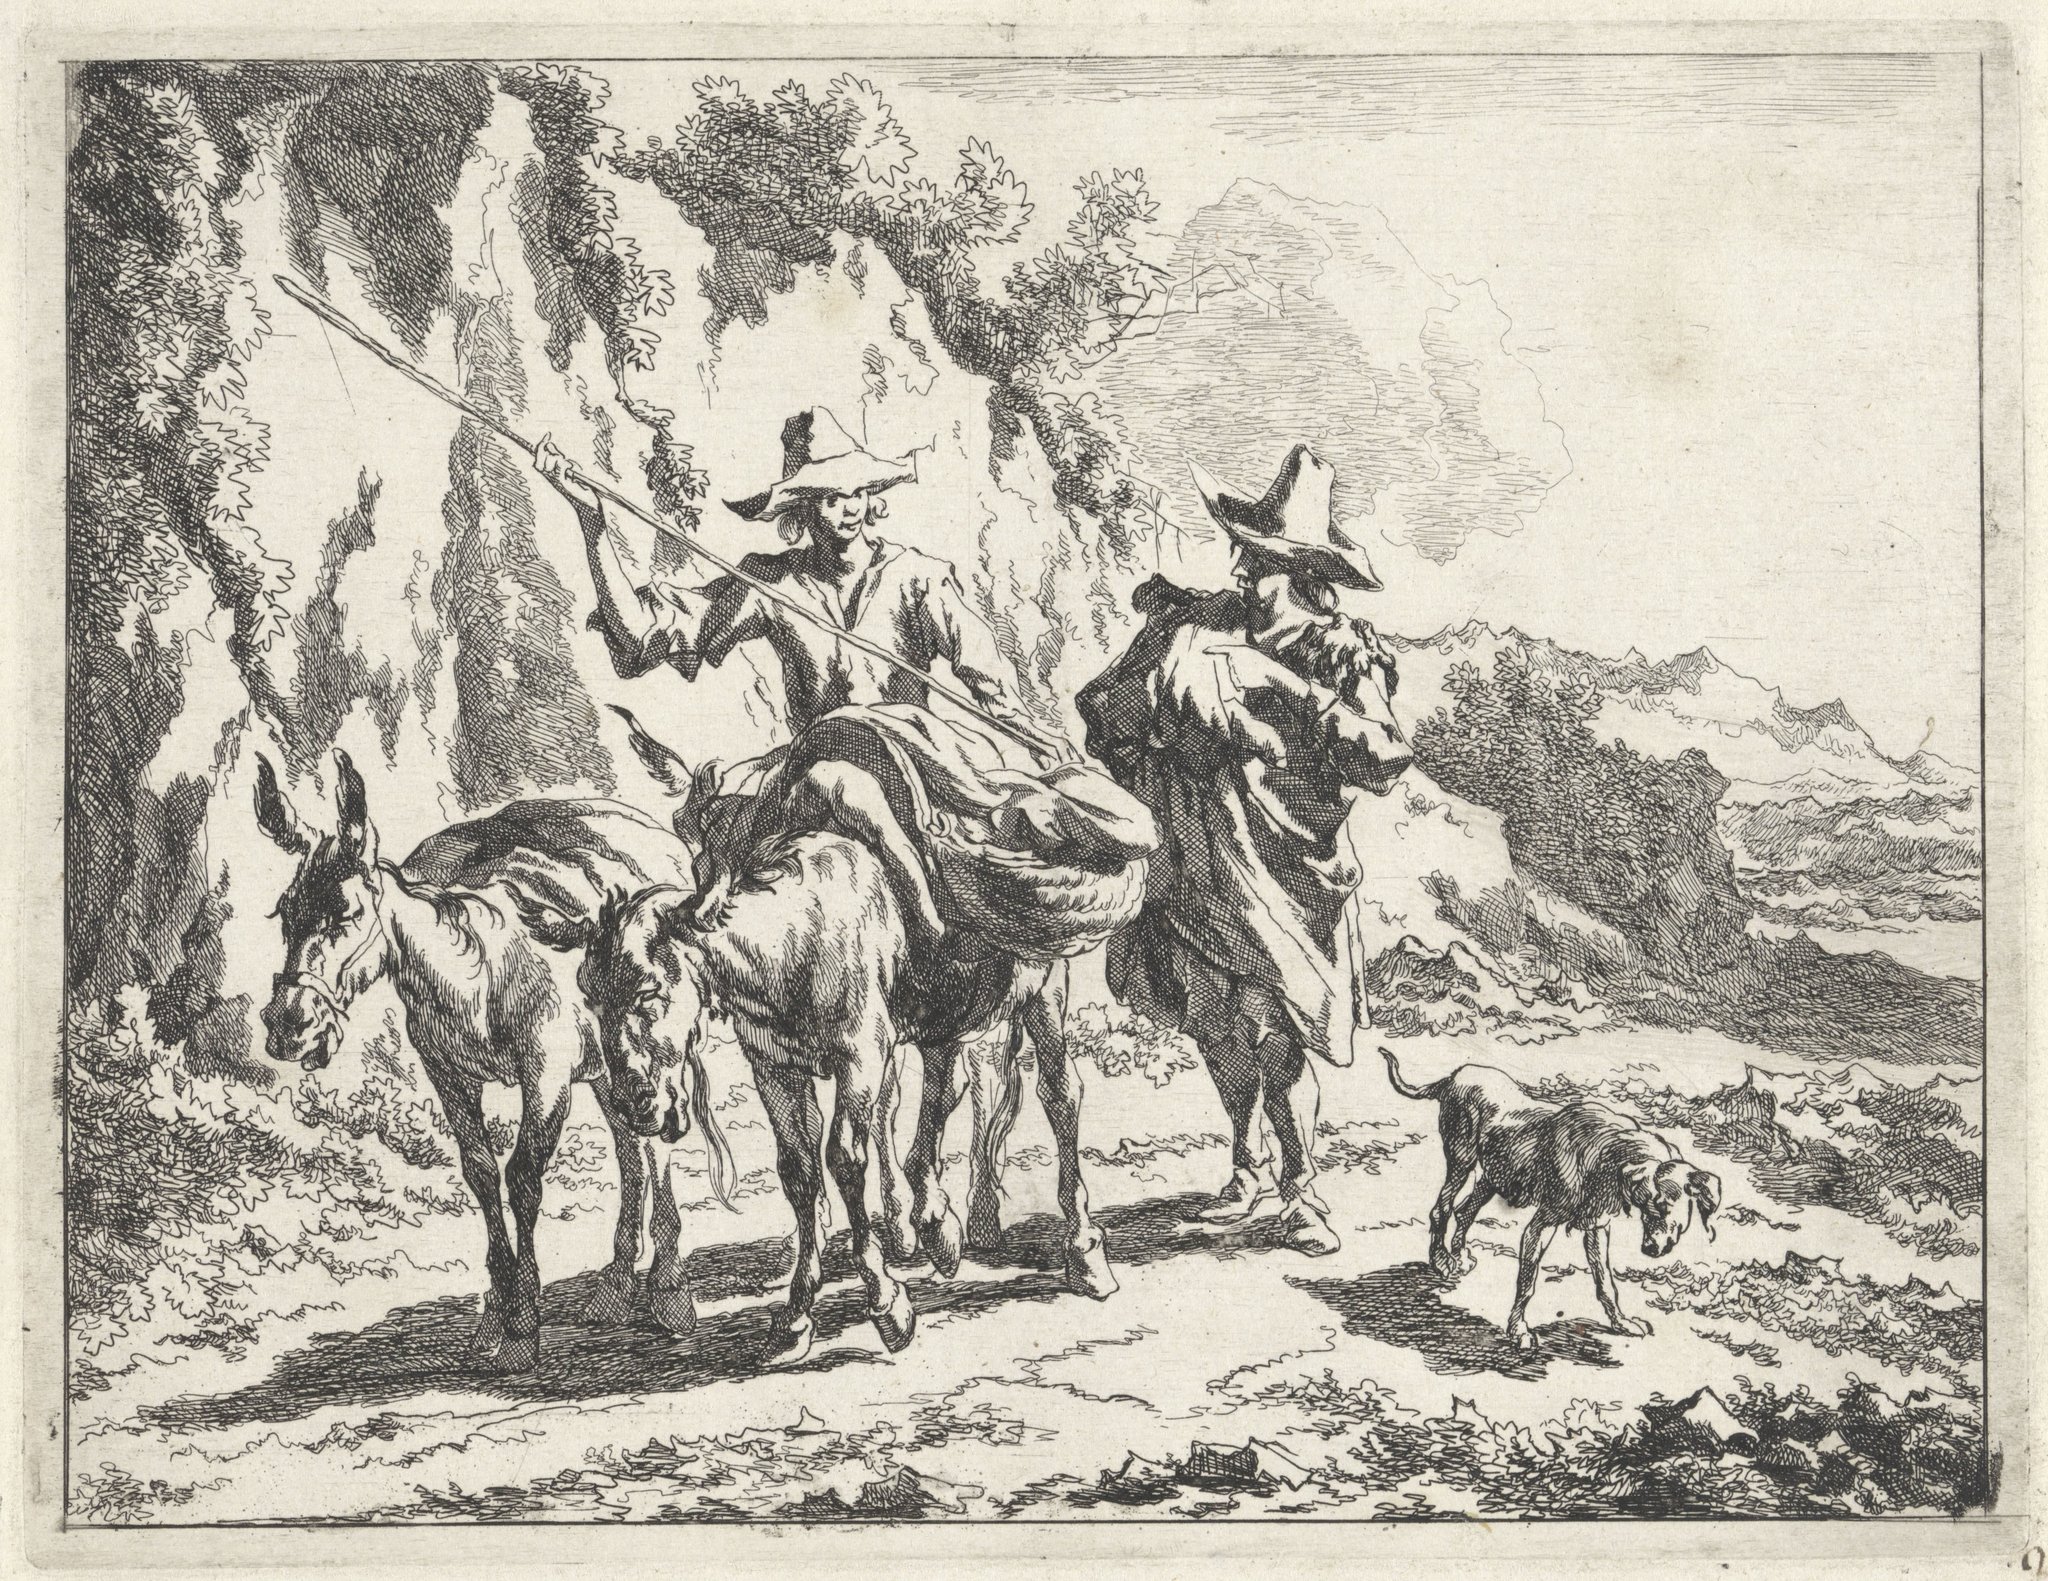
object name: print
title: Herder in gesprek met een jonge herder op een ezel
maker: jan de visscher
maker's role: print maker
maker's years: 1633-1712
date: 1643-1670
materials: paper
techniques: etching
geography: northern netherlands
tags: ass, donkey, herding, herdsman, herdswoman, shepherd, shepherdess, cowherd, etc., conversation, dialogue; conversation piece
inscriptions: collector's mark: Lugt 11, collector's mark: Lugt 10